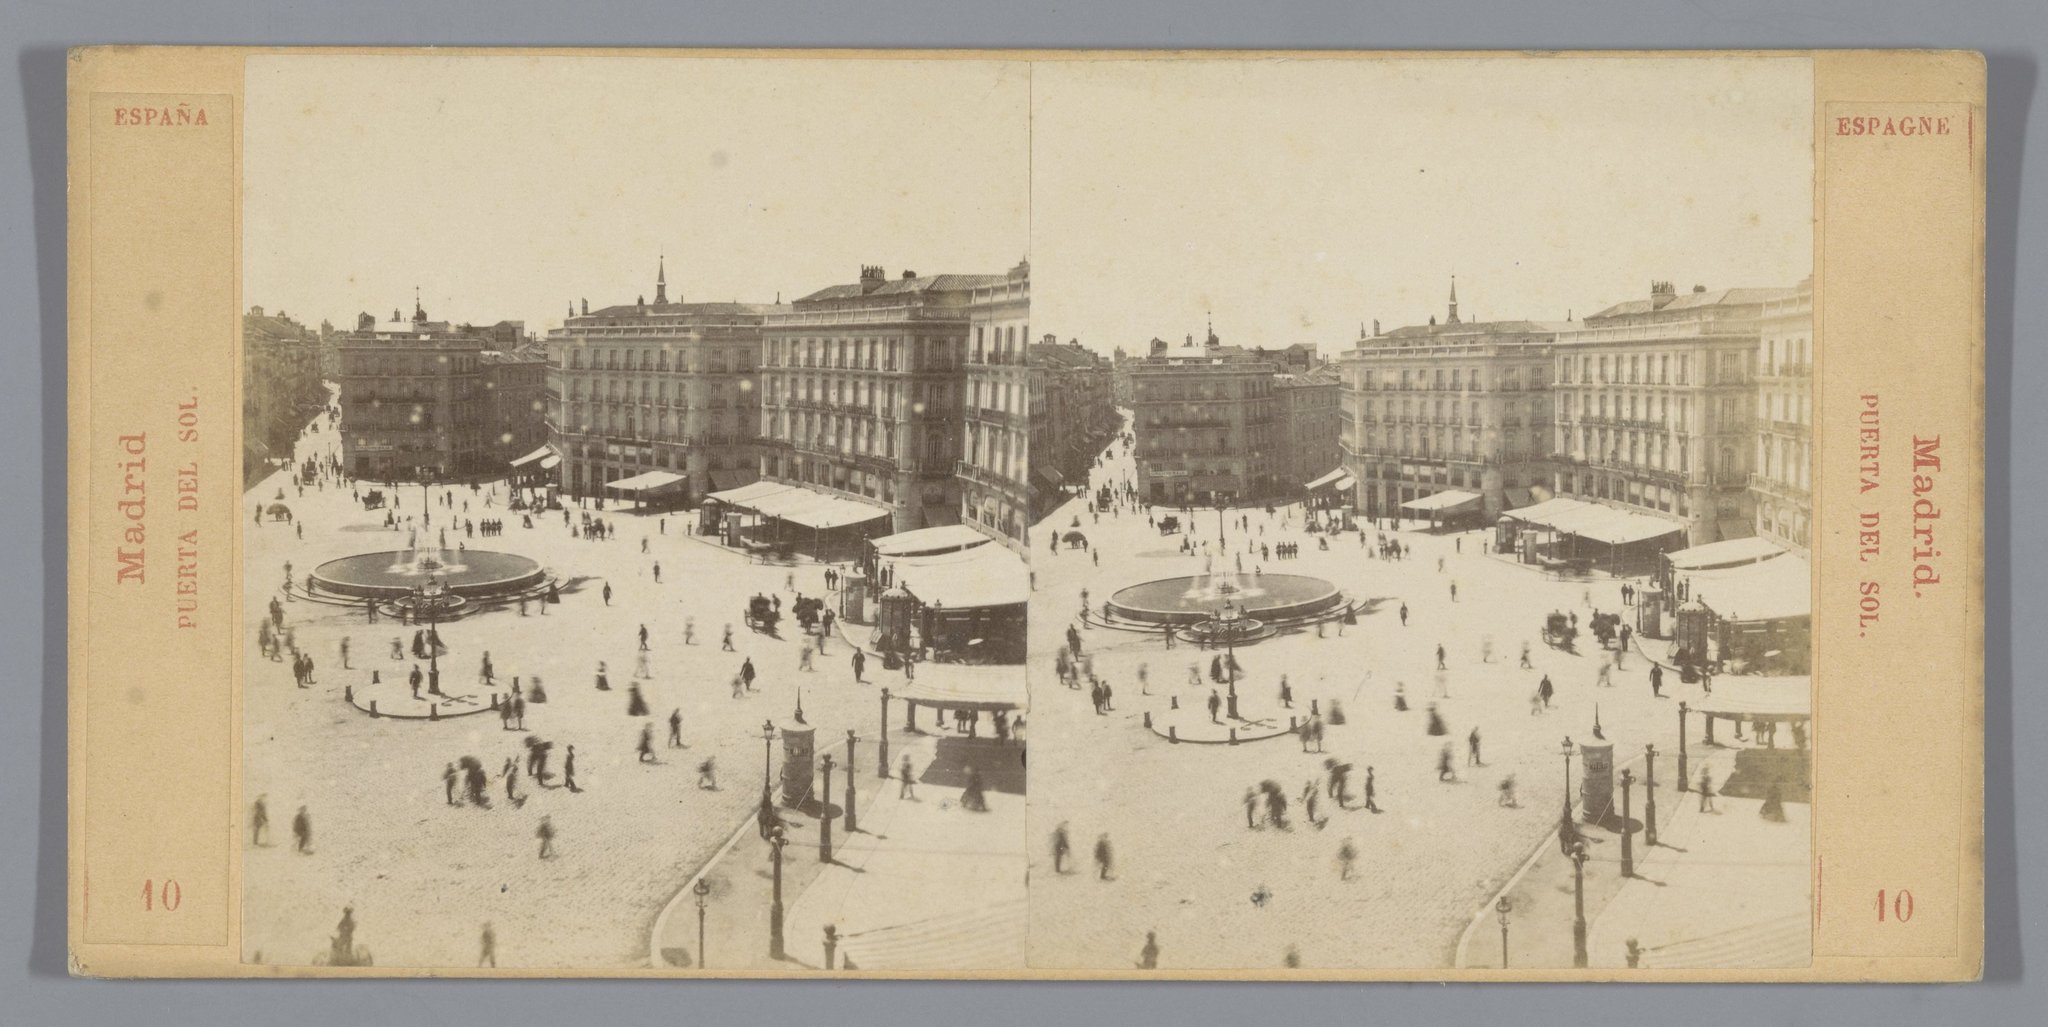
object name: stereograph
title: Madrid, Puerta del Sol.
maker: Anonymous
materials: cardboard, photographic support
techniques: albumen print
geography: palacio de galiana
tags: square, place, circus, etc.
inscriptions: inscription: ‘España’, number: ‘10’